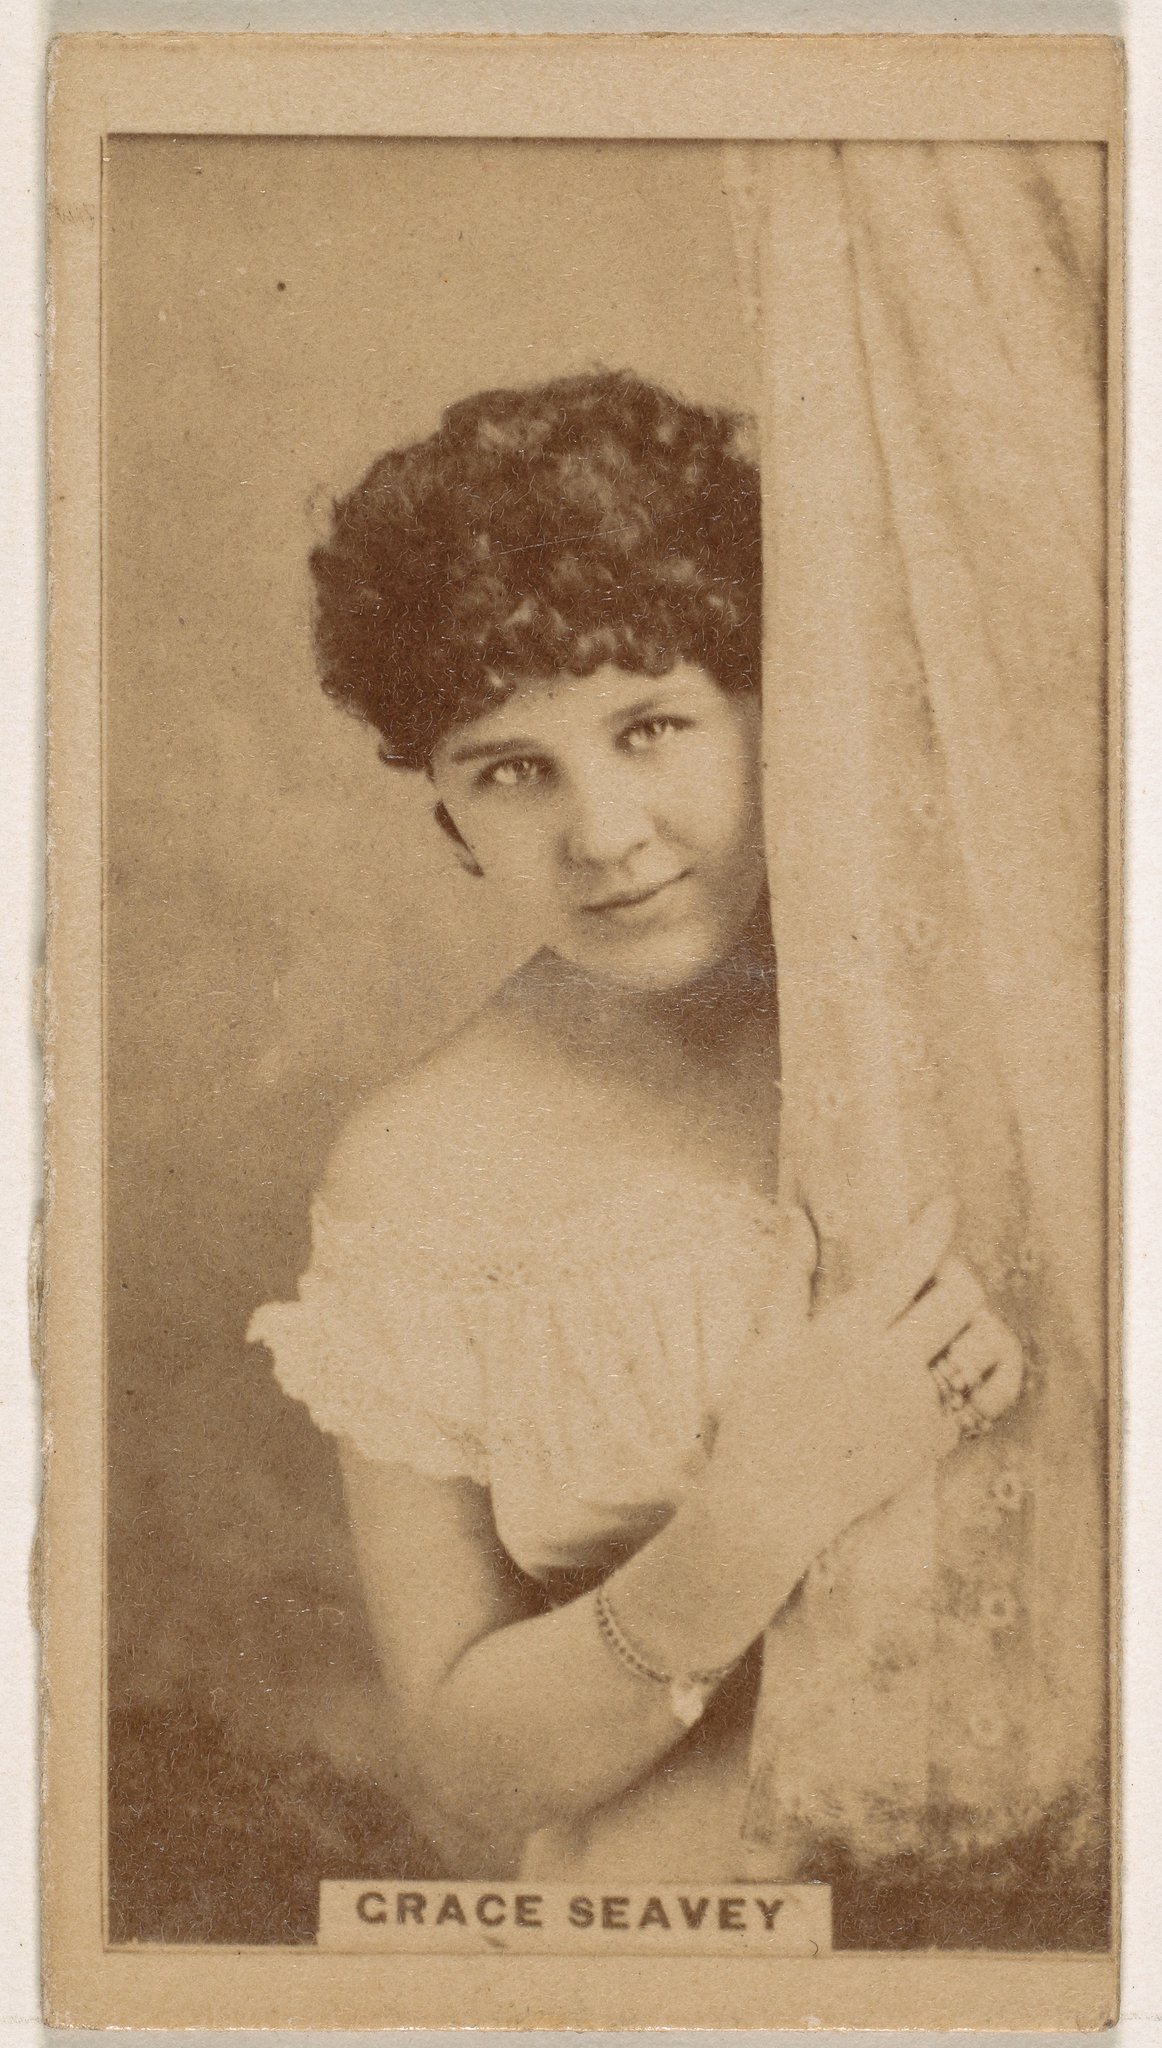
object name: photograph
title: Grace Seavey, from the Actresses series (N245) issued by Kinney Brothers to promote Sweet Caporal Cigarettes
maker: kinney brothers tobacco company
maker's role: publisher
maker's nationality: american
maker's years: 1869-2011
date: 1890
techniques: albumen silver print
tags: portraits,women,actresses